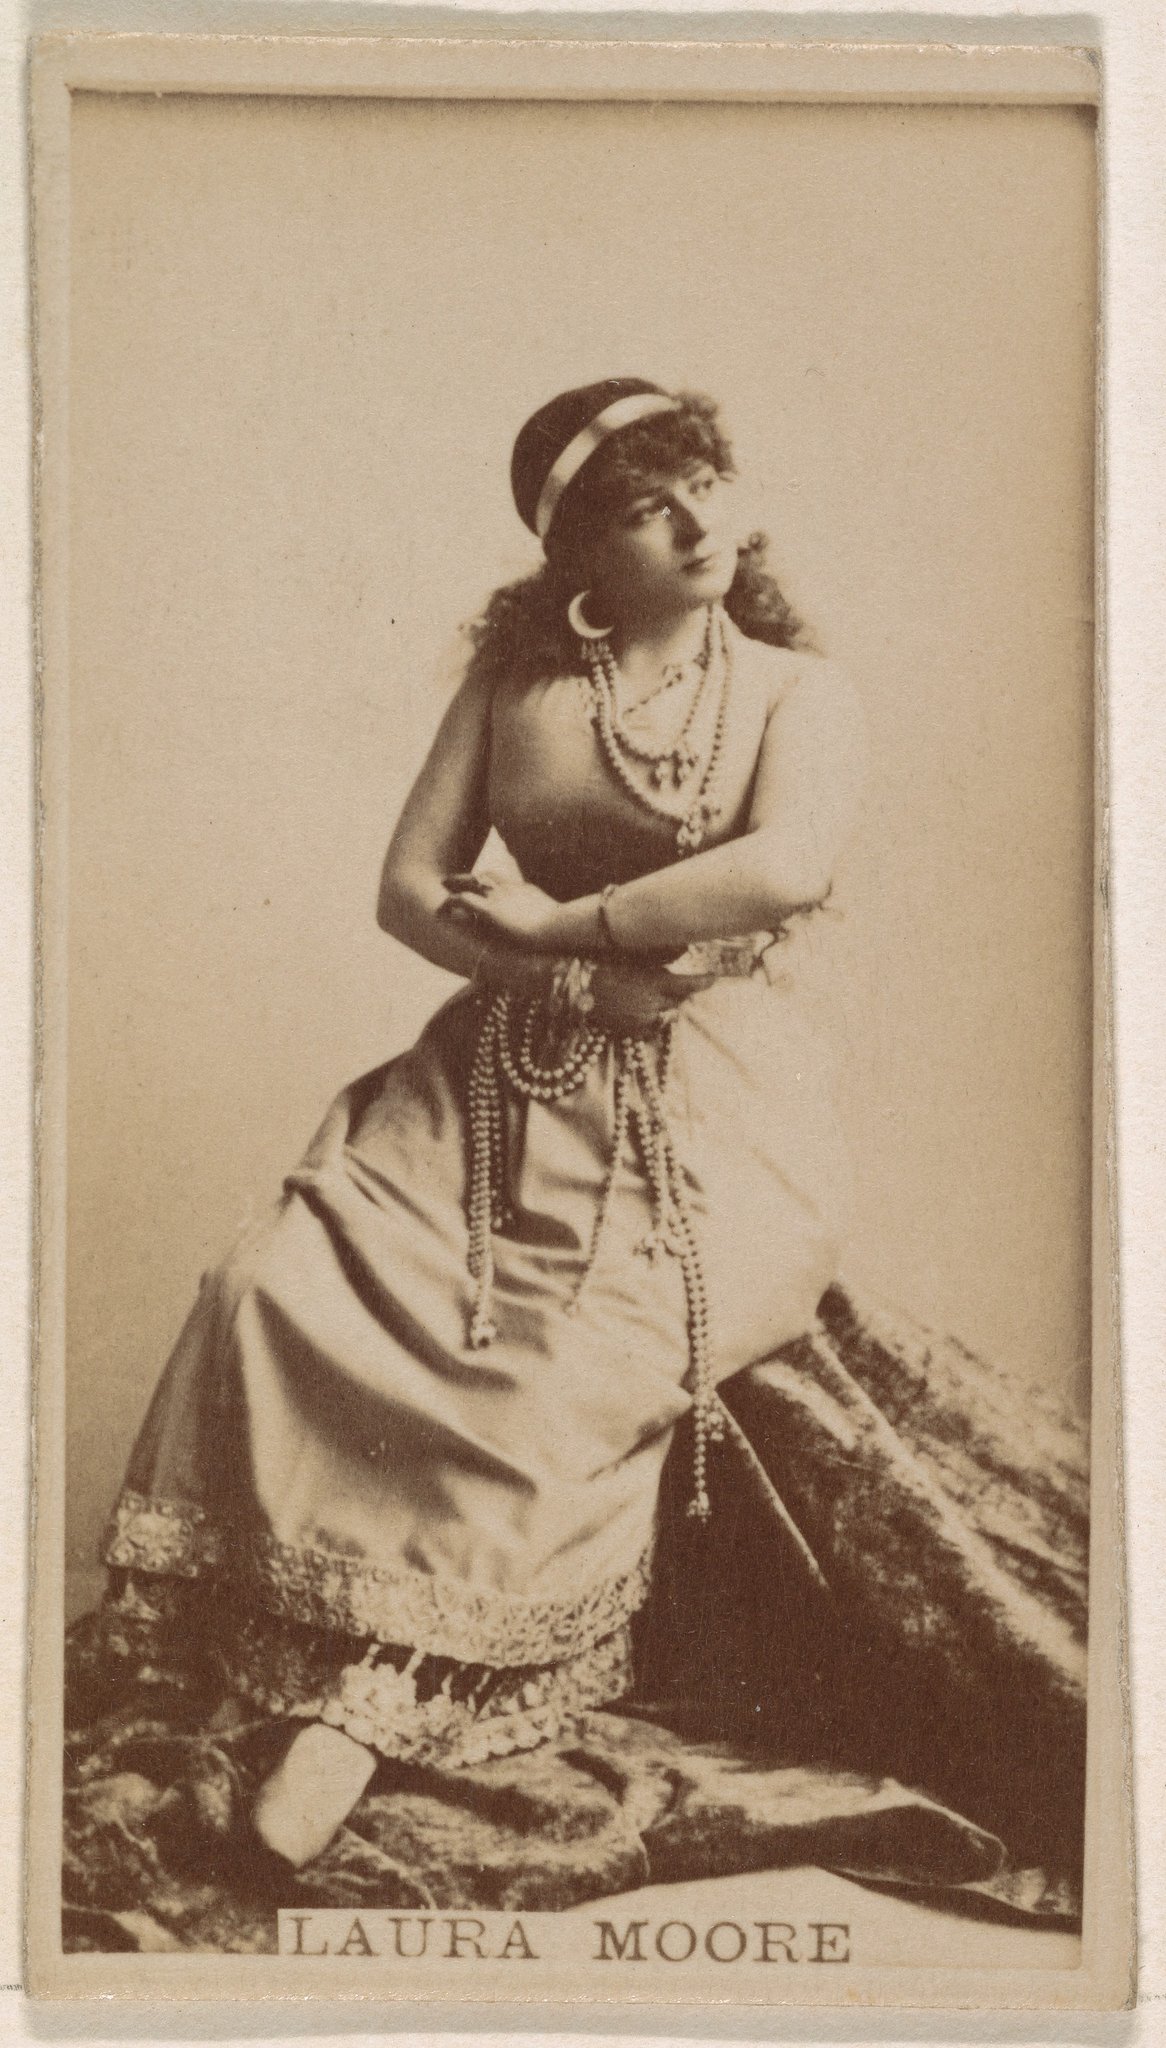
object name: photograph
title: Laura Moore, from the Actresses series (N245) issued by Kinney Brothers to promote Sweet Caporal Cigarettes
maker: kinney brothers tobacco company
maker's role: publisher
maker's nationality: american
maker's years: 1869-2011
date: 1890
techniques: albumen silver print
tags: portraits,women,actresses